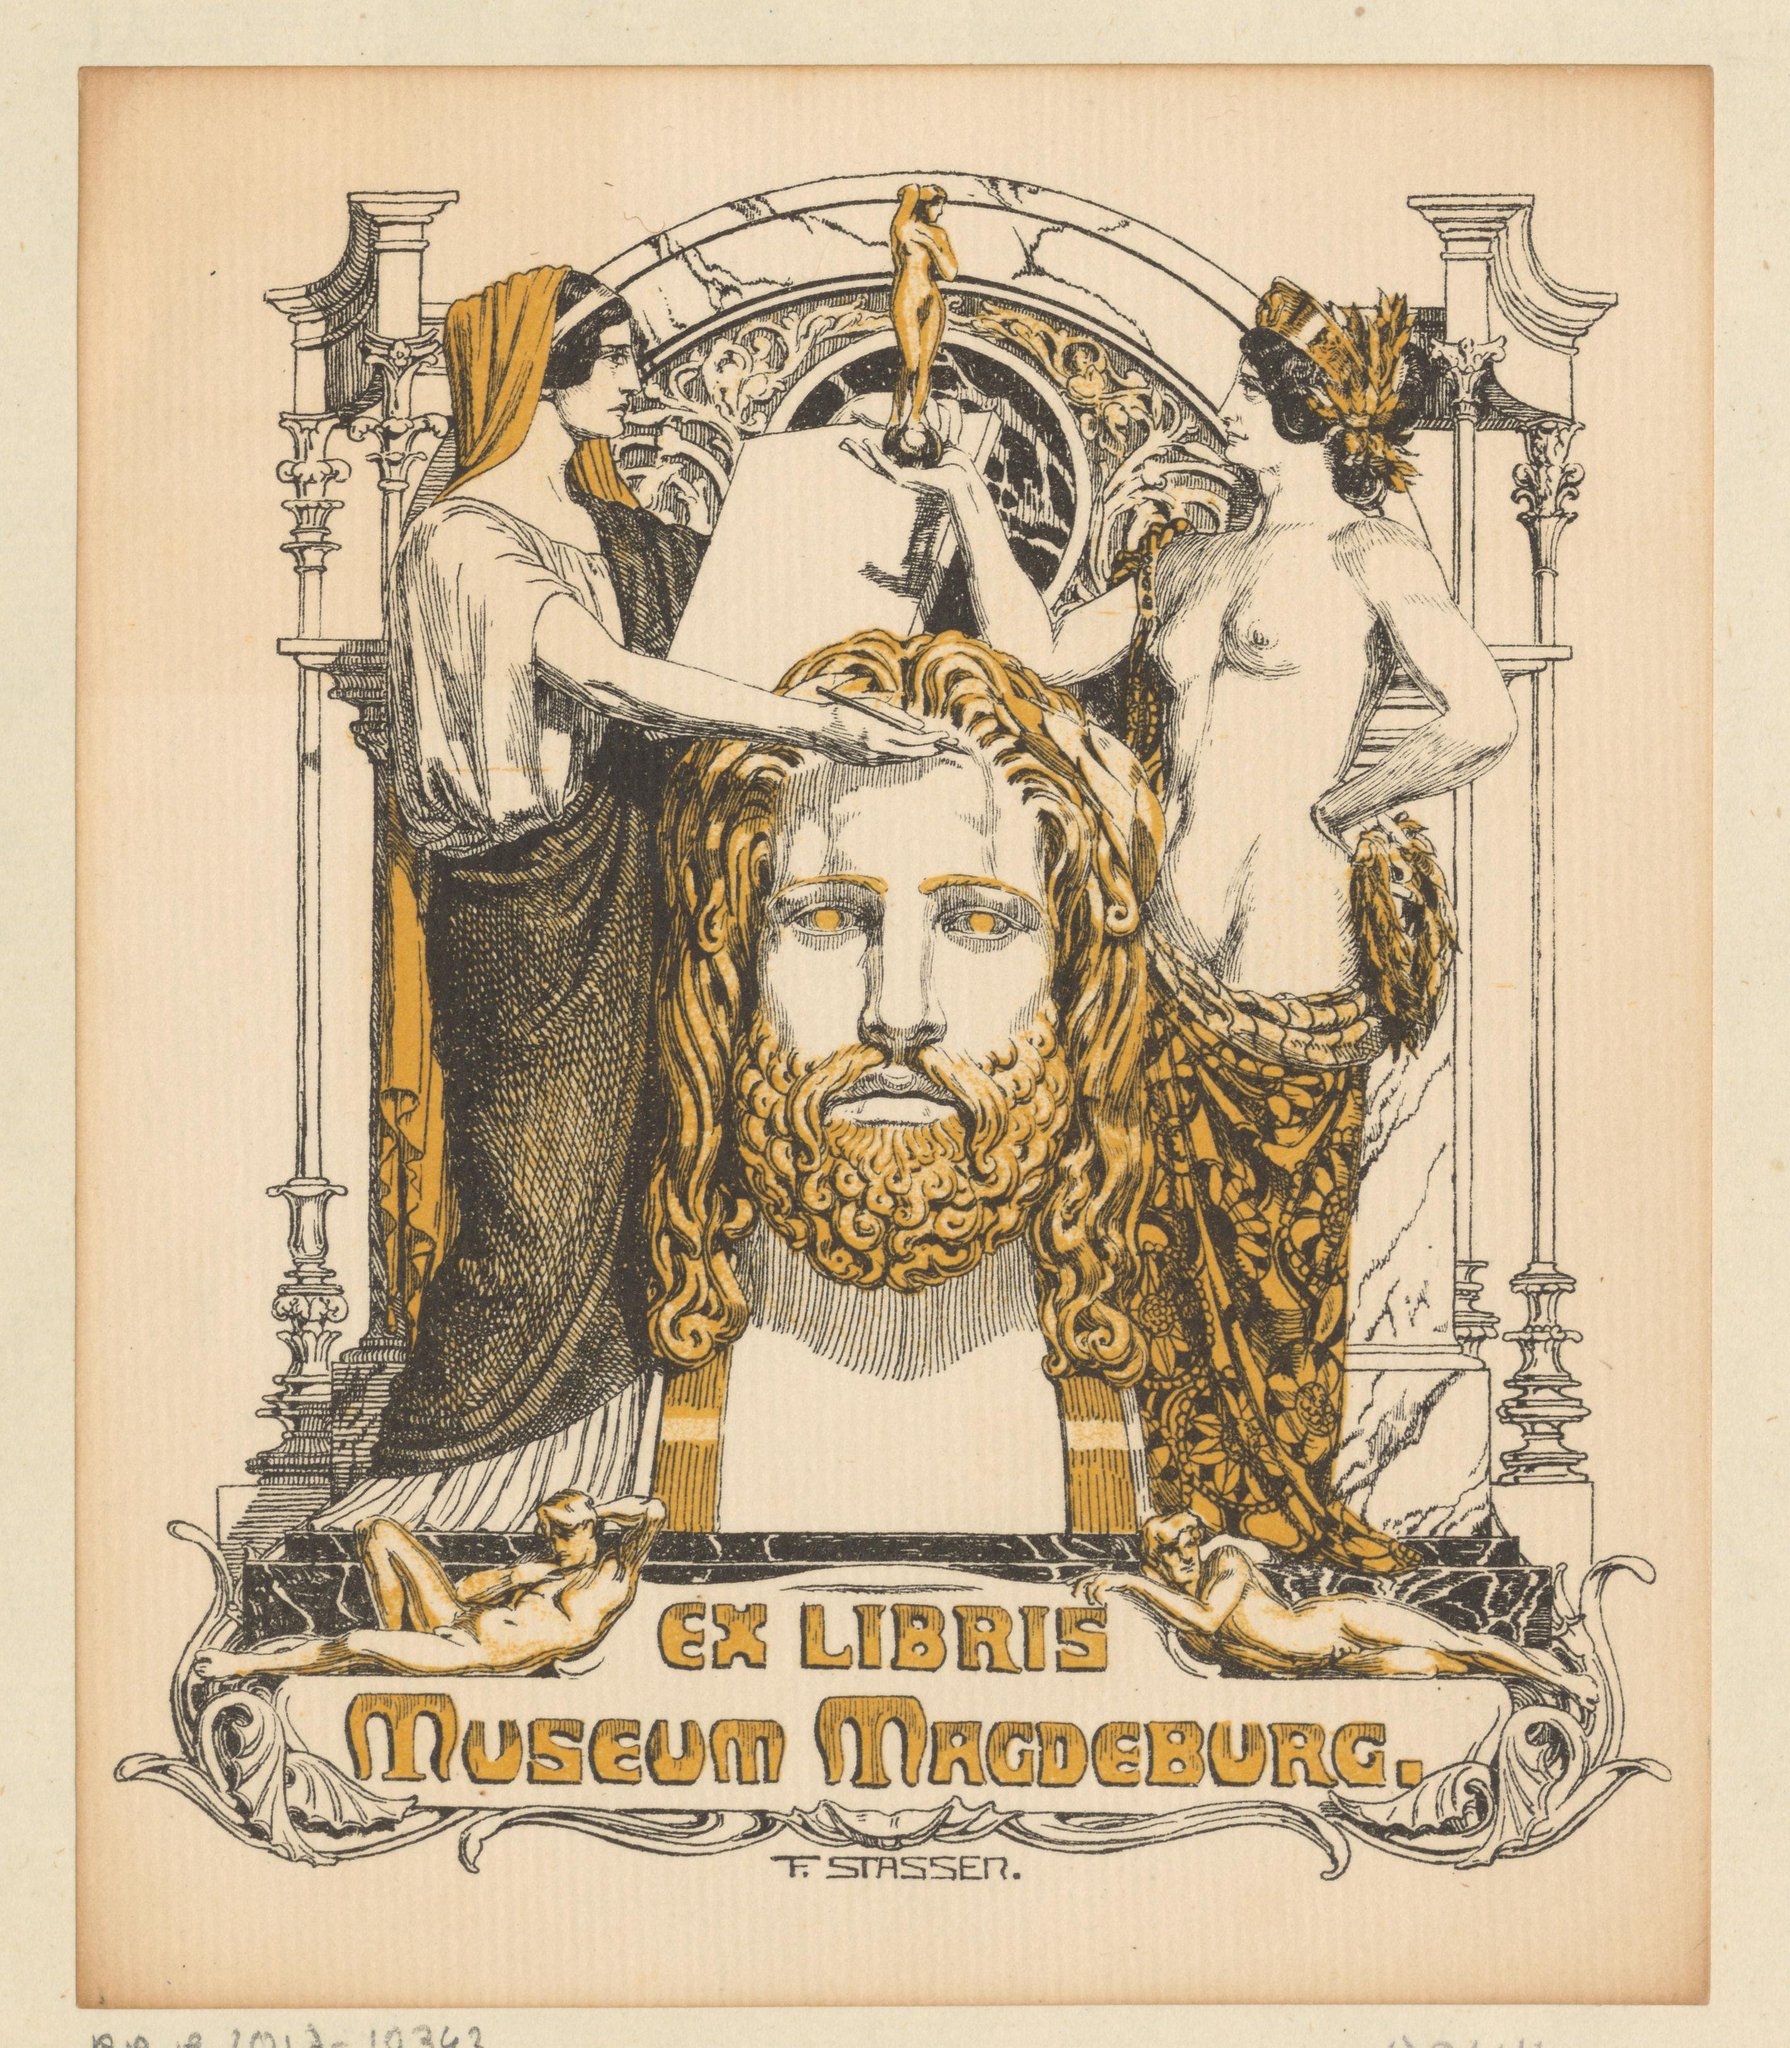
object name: bookplate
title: Ex libris van het Museum Magdeburg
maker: franz stassen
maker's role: painter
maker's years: 1869-1949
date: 1900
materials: paper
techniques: lithograph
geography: germany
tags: 'pictura', symbolic representations, allegories and emblems ~ painting; 'pittura' (ripa), (story of) jupiter (zeus), woman (showing herself) undressed, quasi-nude, sculpture